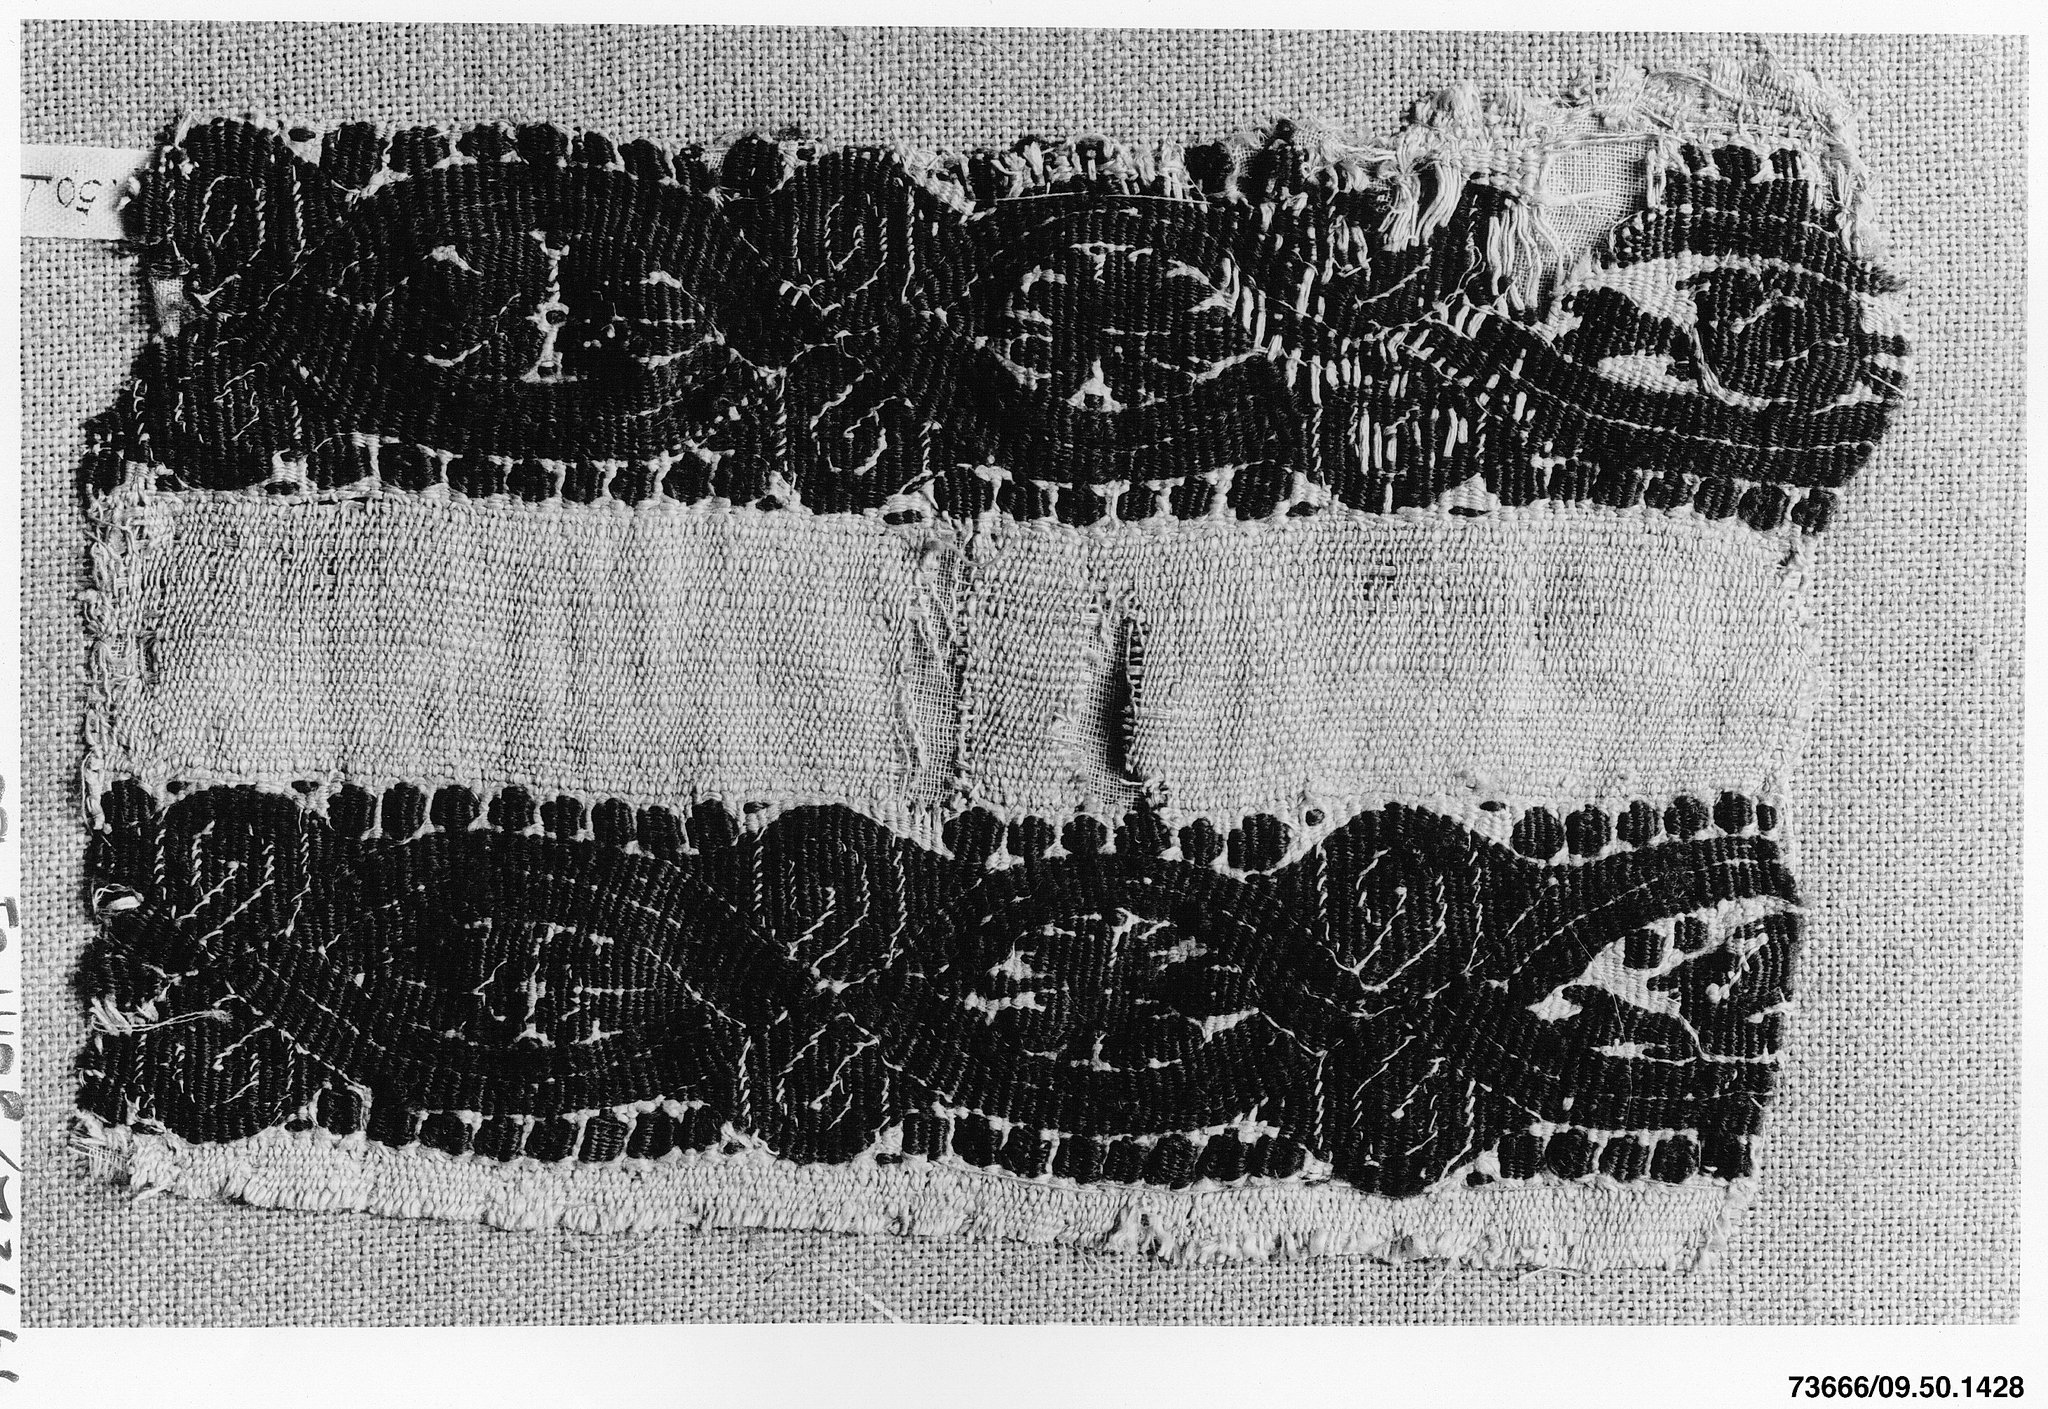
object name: textile fragment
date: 301-500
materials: linen, wool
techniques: weave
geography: egypt